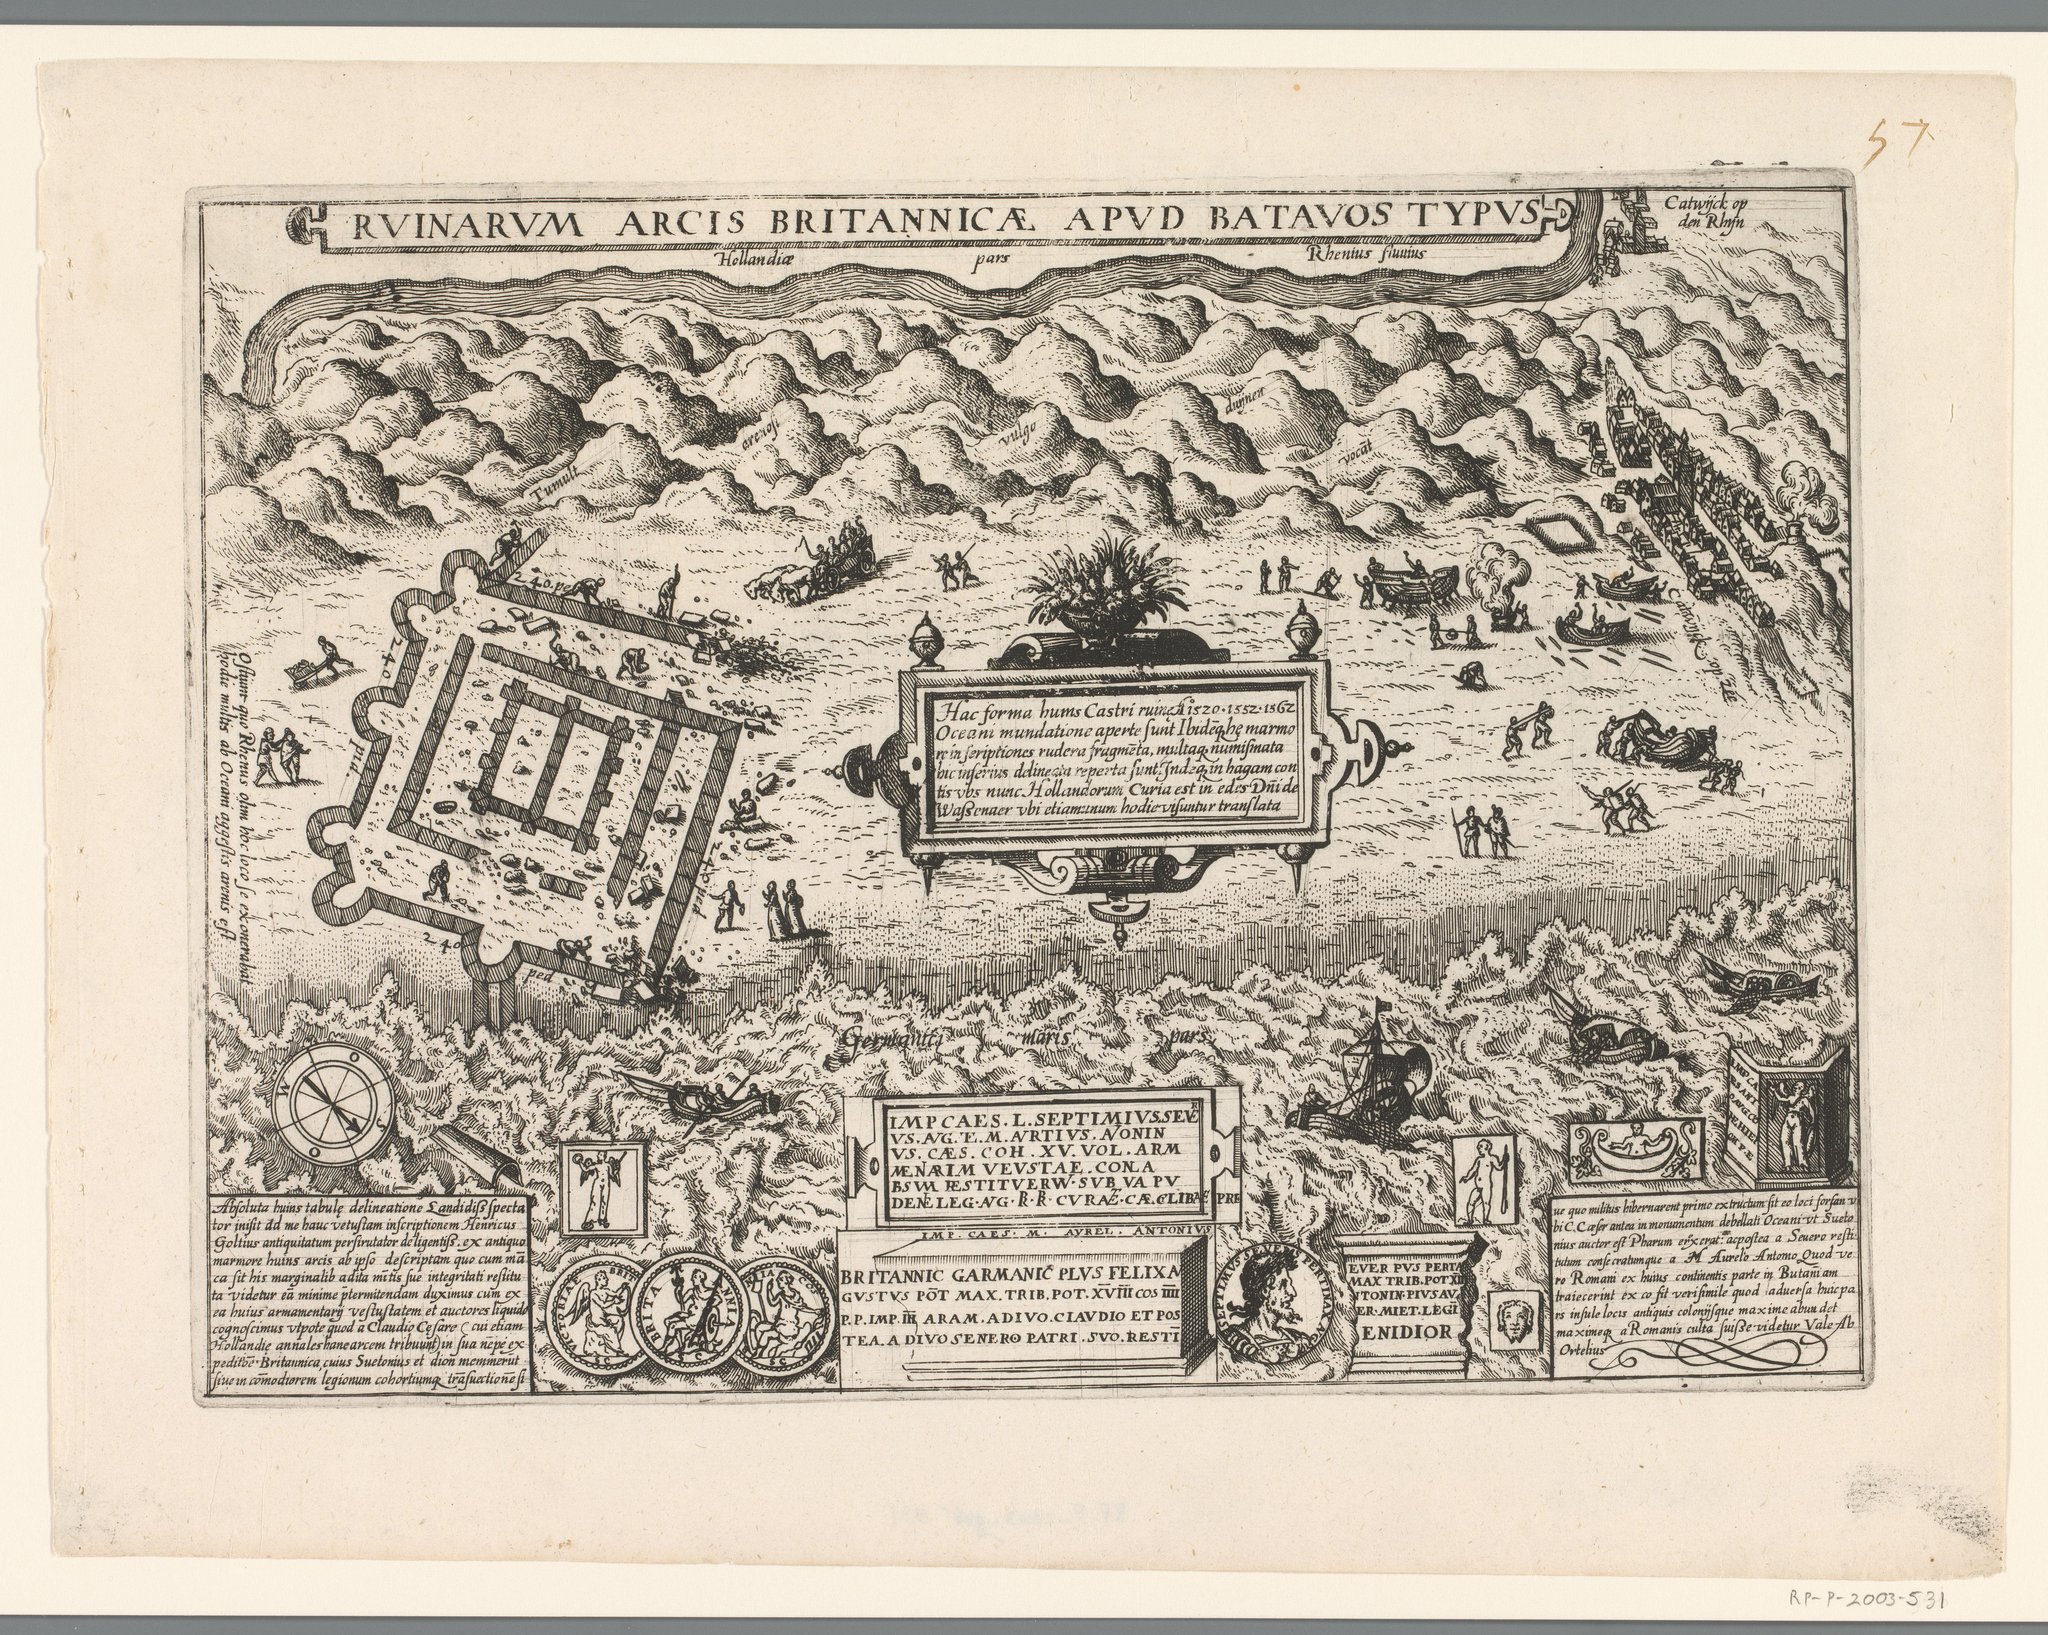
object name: print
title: Plattegrond van Brittenburg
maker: Anonymous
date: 1607-1609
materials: paper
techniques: etching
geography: northern netherlands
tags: dune coast, ruin of a building ~ architecture, landscape with ruins, ruin of a dwelling, house, castle, etc.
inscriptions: number: ‘57’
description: Aanzicht van de duinen bij Katwijk met op het strand een plattegrond van de ruïnes van Brittenburg. Met enkele van de daar gevonden munten en beeldhouwwerken. Met verschillende cartouches met teksten in het latijn. Onderdeel van de verzameling kaarten genomen uit een latere editie van: Descrittione di tutti i Paesi Bassi van Lodovico Guicciardini.